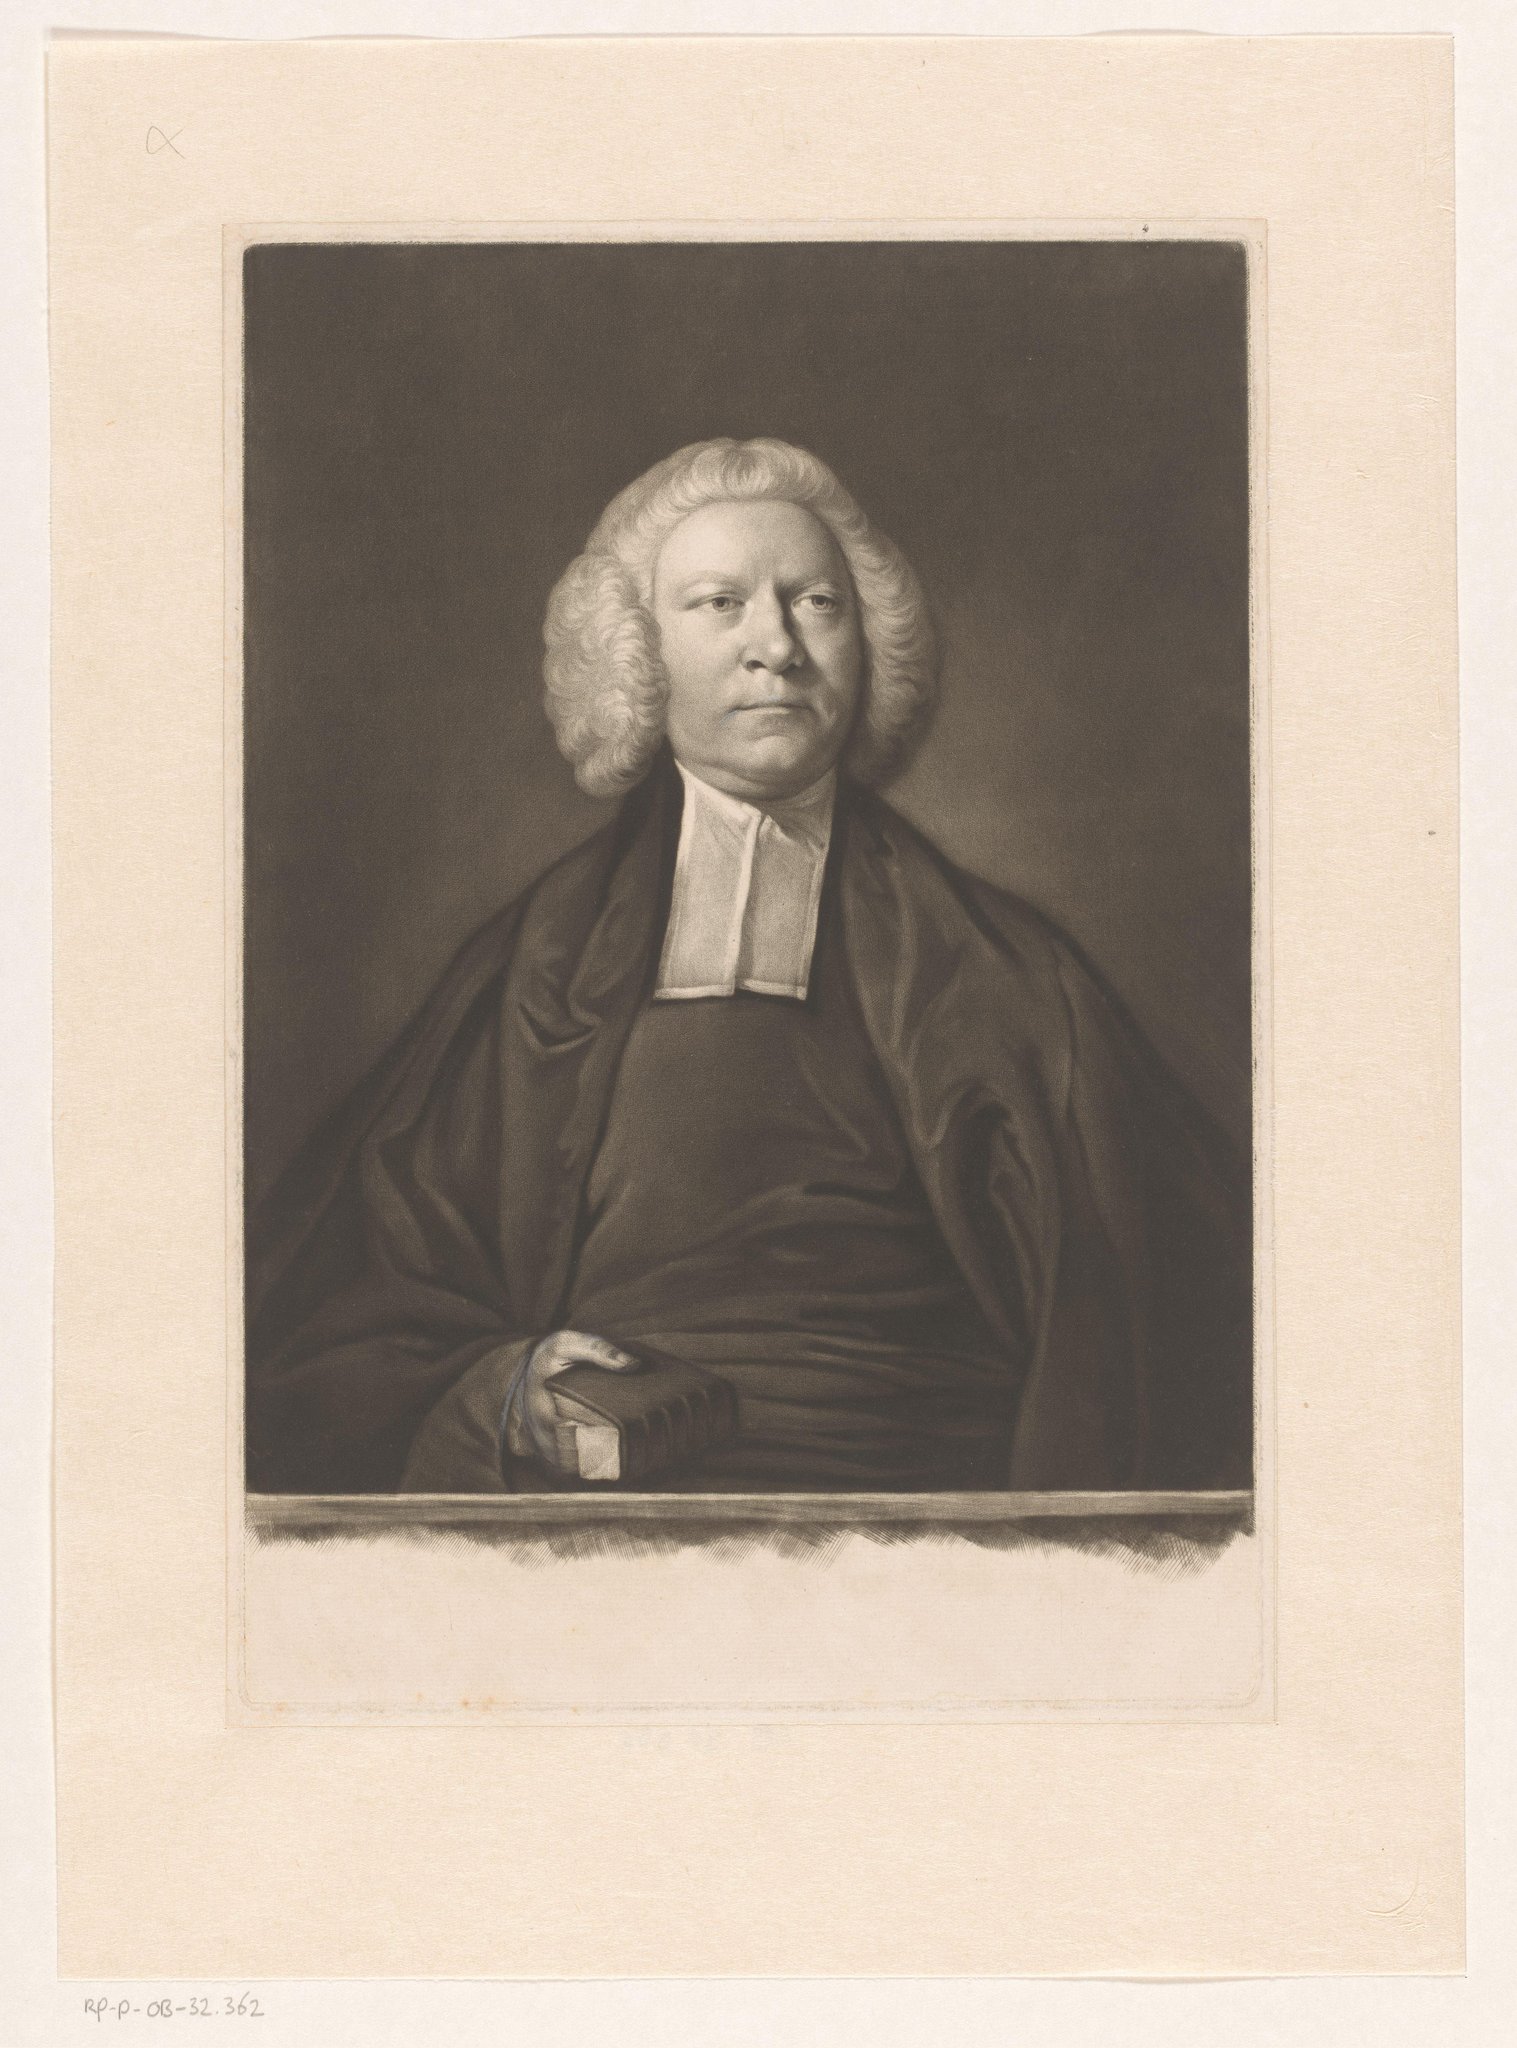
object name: print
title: Portret van Thomas Ashton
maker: james mcardell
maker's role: print maker, publisher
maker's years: 1728-1765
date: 1763-1765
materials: paper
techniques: mezzotint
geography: london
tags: clergyman, historical persons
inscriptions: collector's mark: Lugt 240